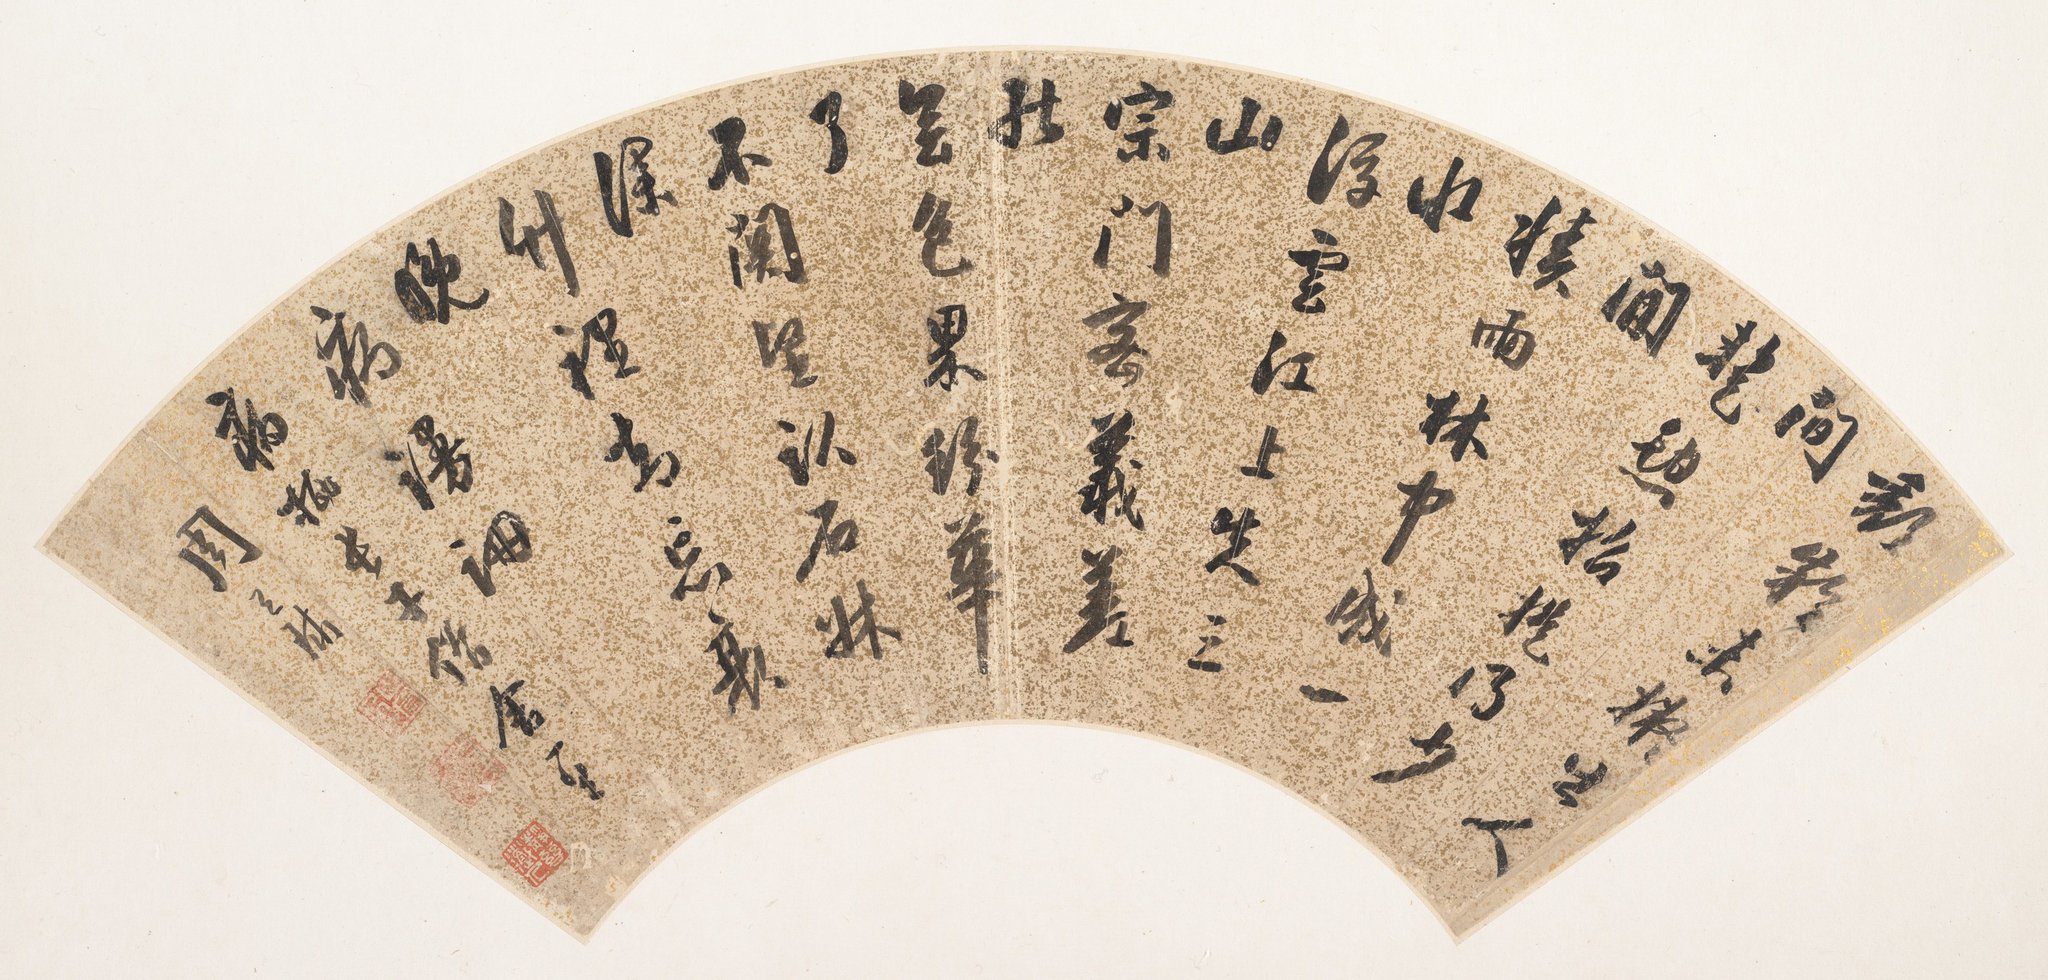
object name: folding fan mounted a an album leaf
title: Calligraphy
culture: chinese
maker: zhou tianqiu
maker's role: artist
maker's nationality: chinese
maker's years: 1514-1595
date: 1514-1595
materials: gold, ink, paper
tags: calligraphy